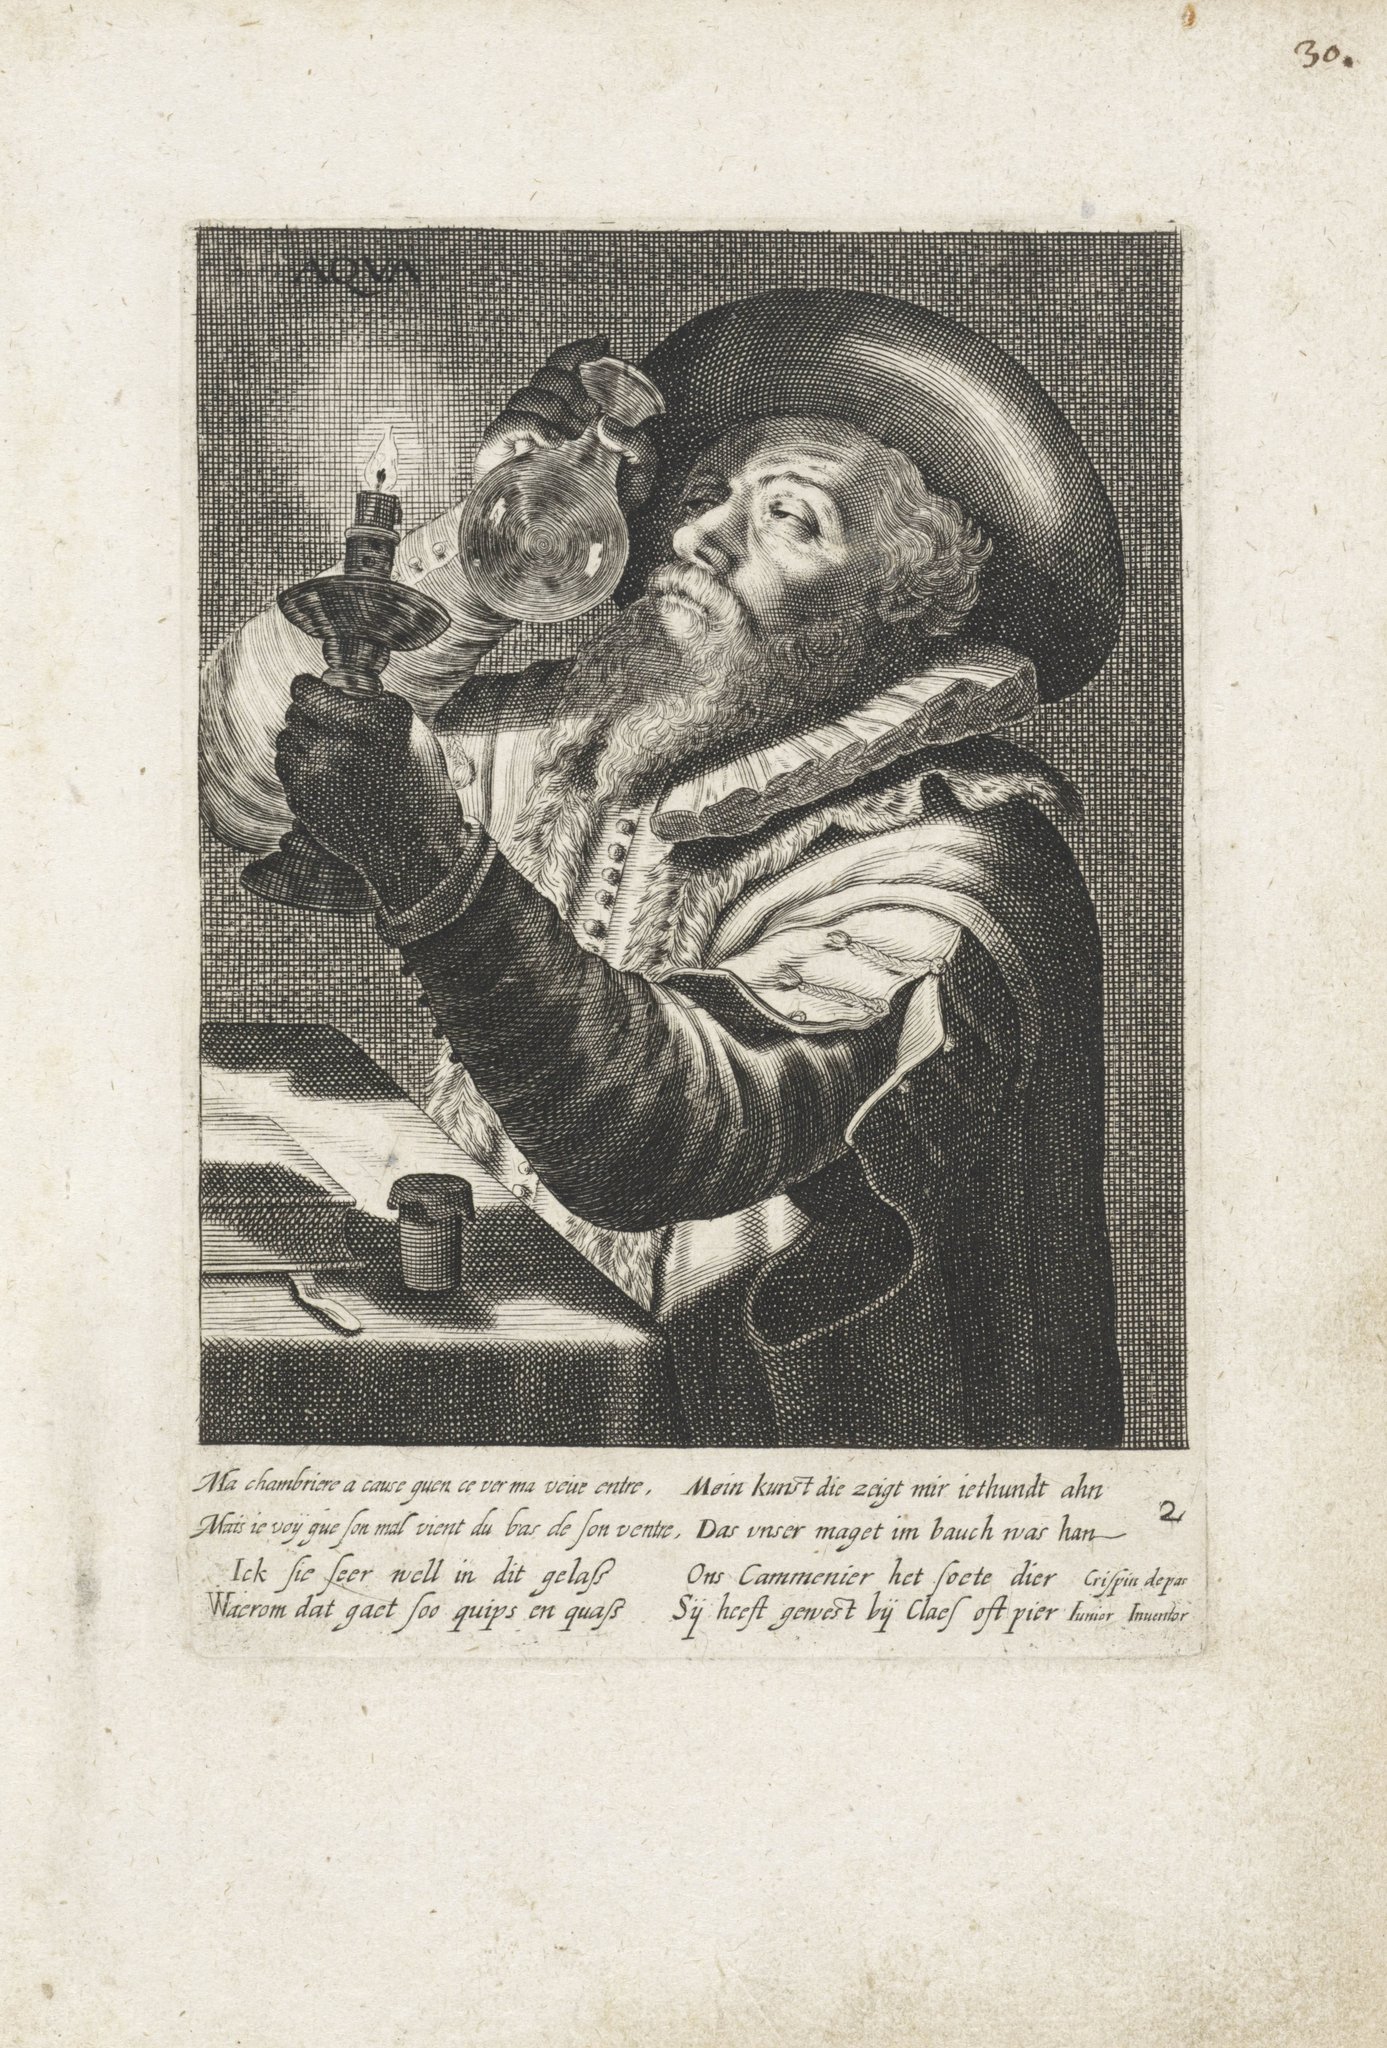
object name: print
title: Aqua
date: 1613-1720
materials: paper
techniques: engraving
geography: low countries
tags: water (one of the four elements), examination of urine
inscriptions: collector's mark: Lugt 2228, number: ‘30’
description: Een arts met een baard en een flambard kijkt bij kaarslicht in een urinaal. Voor hem een tafel waarop een boek en een pot. Onder een tweeregelig onderschrift in het Frans en Duits en een vierregelig onderschrift in het Nederlands.